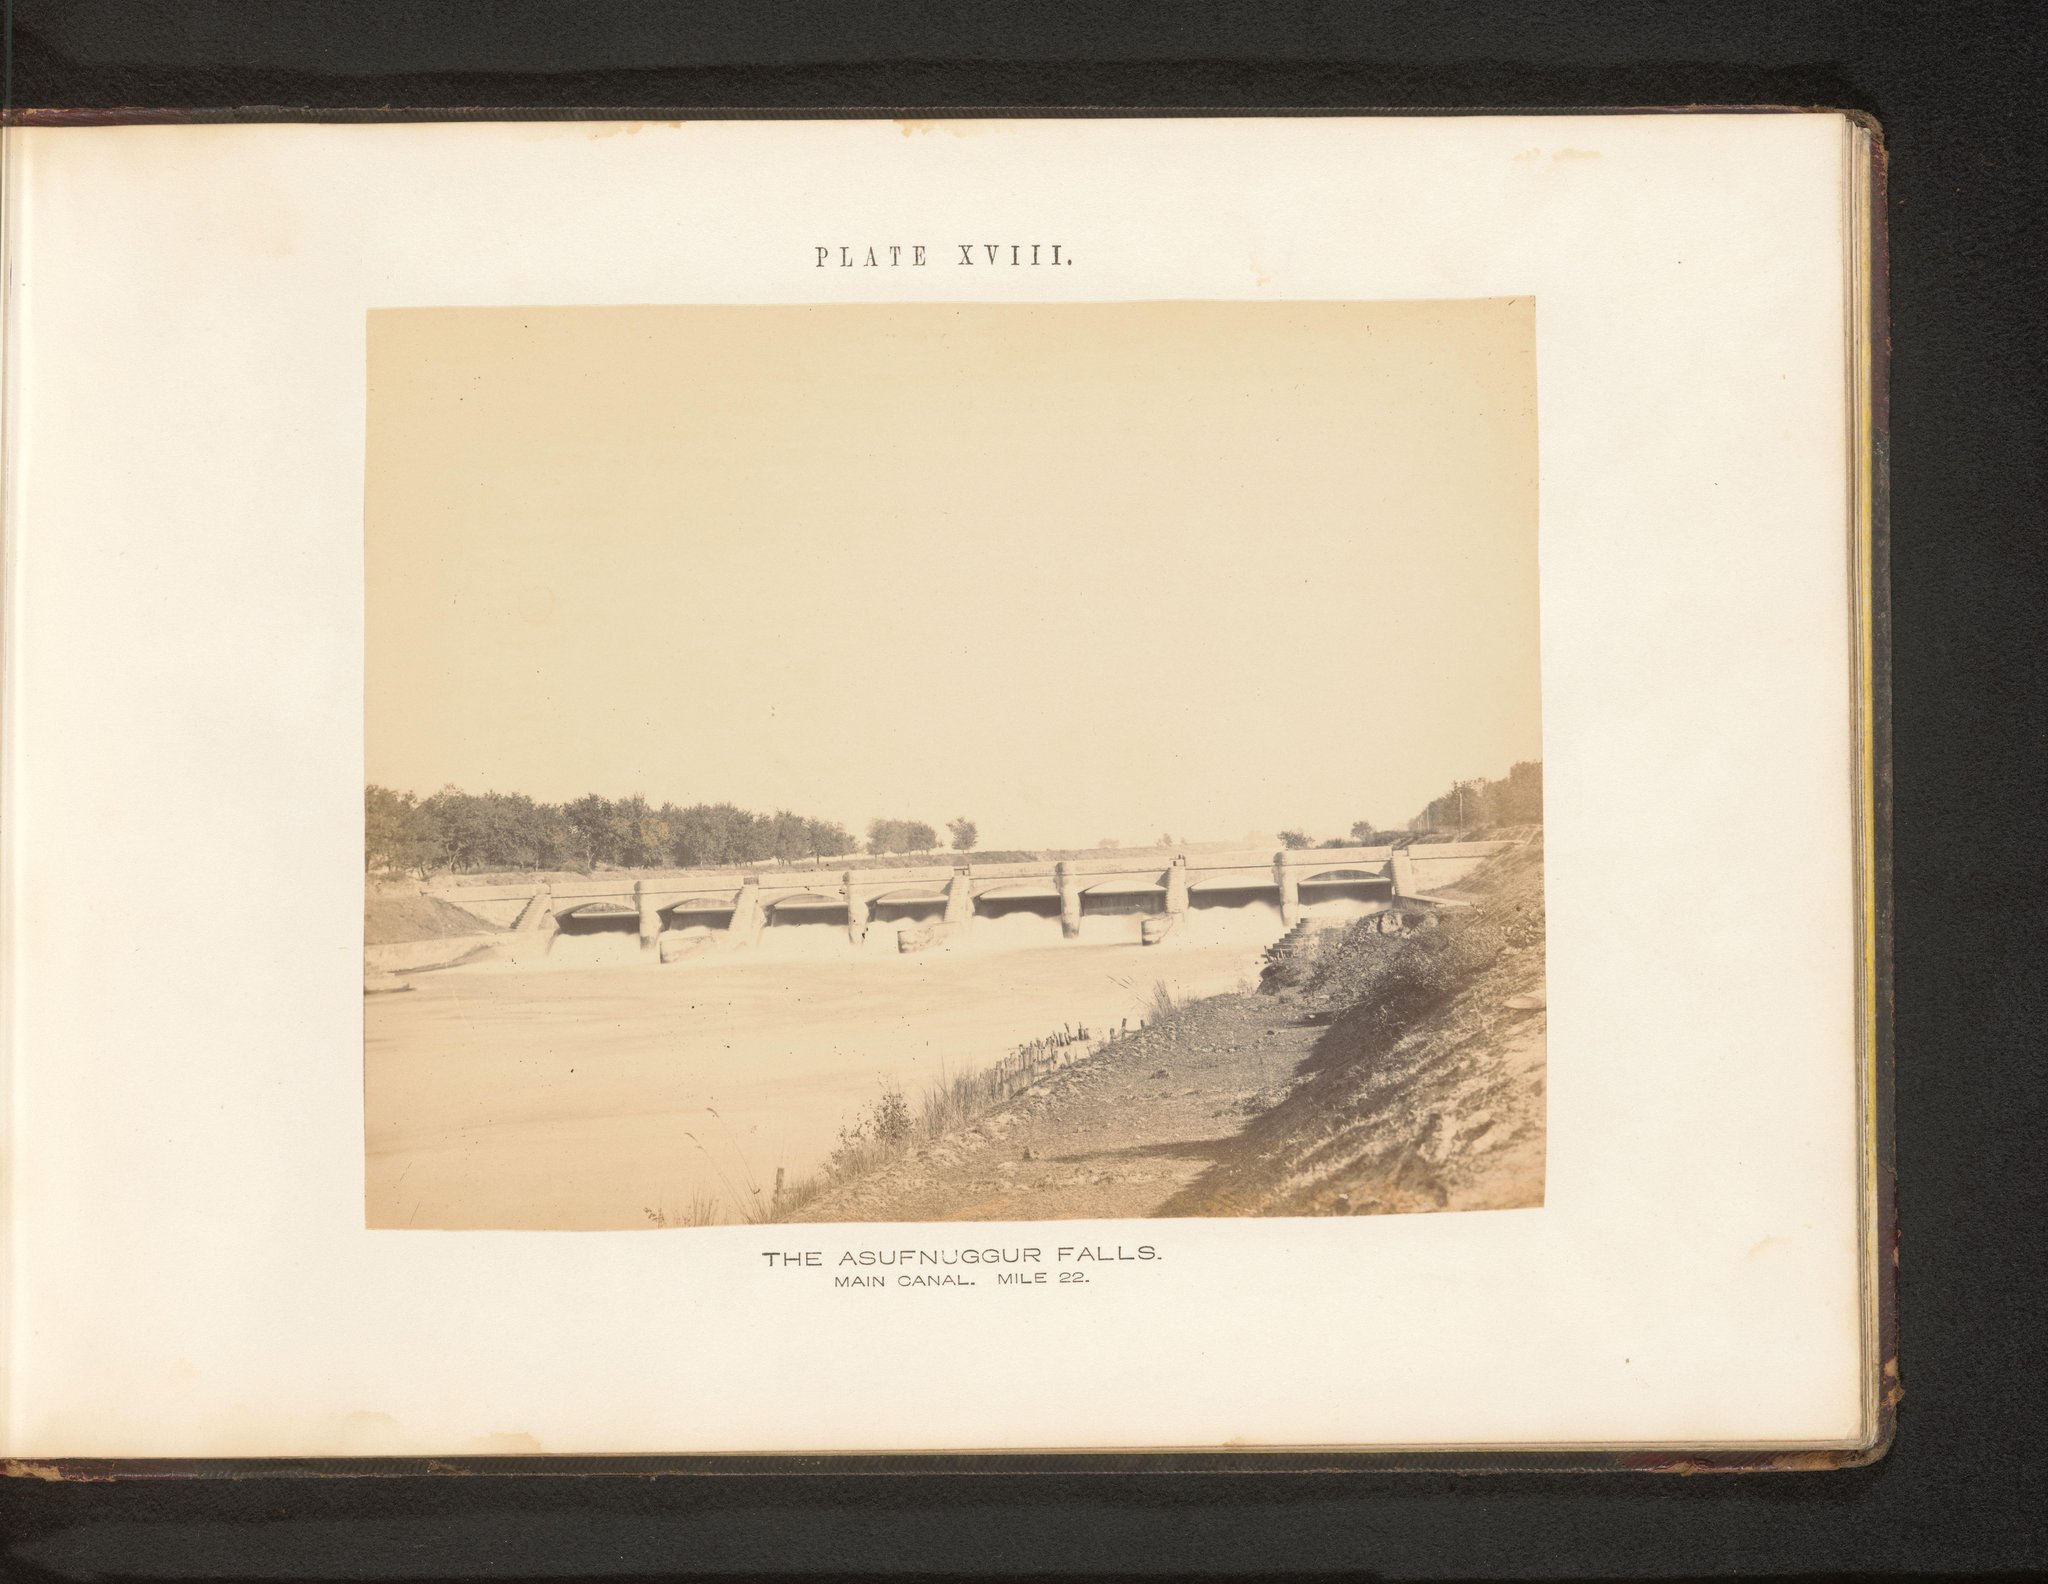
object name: photograph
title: Gezicht op een dam in de Ganges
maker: thomas george glover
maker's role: fotograaf, luitenant-kolonel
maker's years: 1825-1881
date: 1862-1867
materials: photographic support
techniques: albumen print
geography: india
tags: dam (in canal), civic architecture; edifices; dwellings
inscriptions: inscription: ‘main canal. mile 22.’, inscription: ‘Plate XVIII’